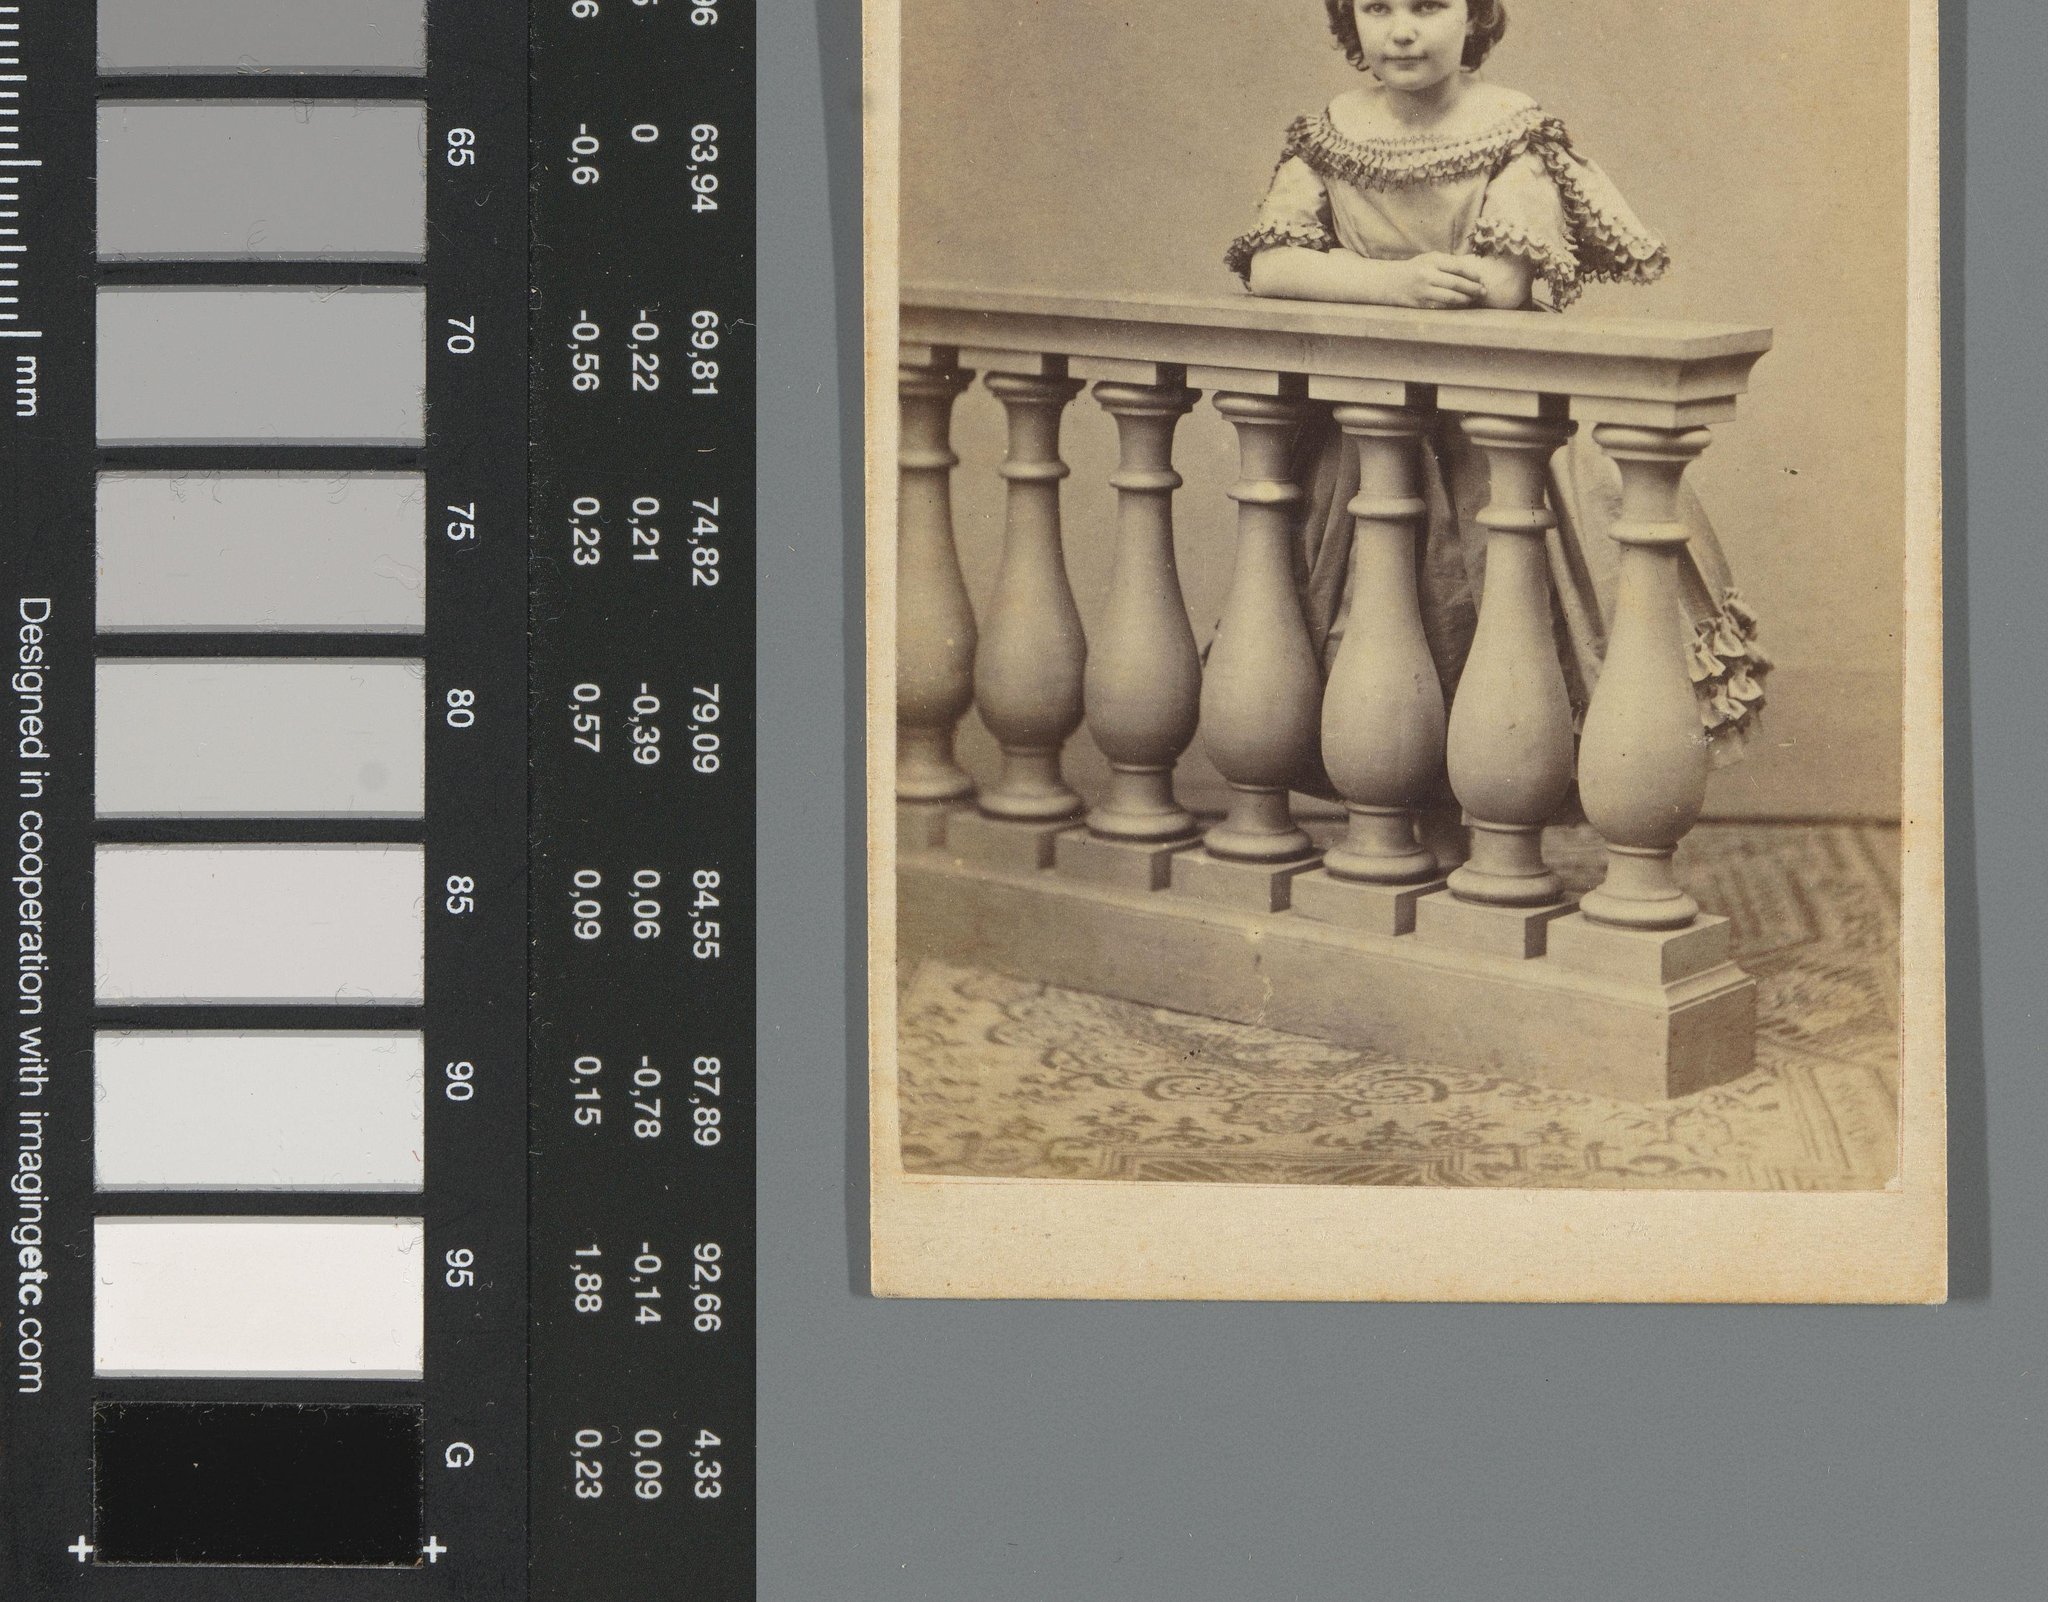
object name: photograph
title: Portret van Henriette Teding van Berkhout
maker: willem tinker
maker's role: fotograaf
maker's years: 1816-1894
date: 1860-1866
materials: cardboard, photographic support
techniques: photography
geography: haarlem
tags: historical persons - bb - woman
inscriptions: annotation: ‘Jet TvB (de Clercq-TvB)’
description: Portret van Henriette Teding van Berkhout, als jong meisje, staande bij een balustrade.